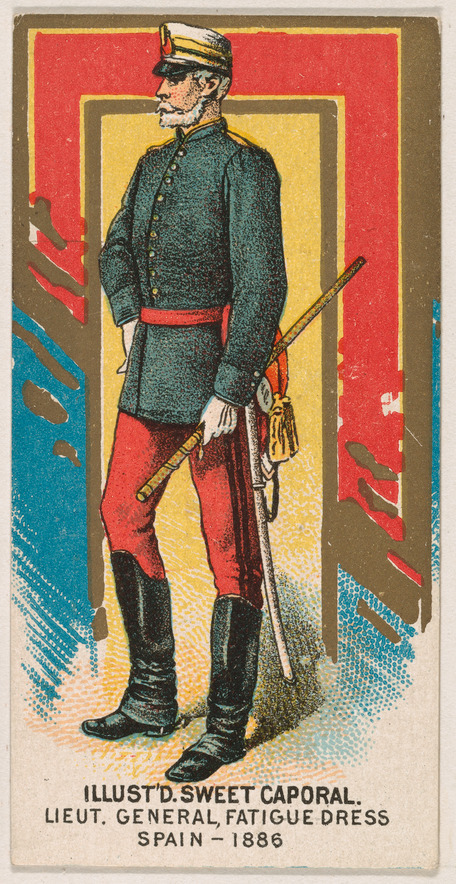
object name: print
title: Lieutenant General, Fatigue Dress, Spain, 1886, from the Military Series (N224) issued by Kinney Tobacco Company to promote Sweet Caporal Cigarettes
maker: kinney brothers tobacco company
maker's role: publisher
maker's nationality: american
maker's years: 1869-2011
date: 1888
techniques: color lithograph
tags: military,weapons,men,profiles